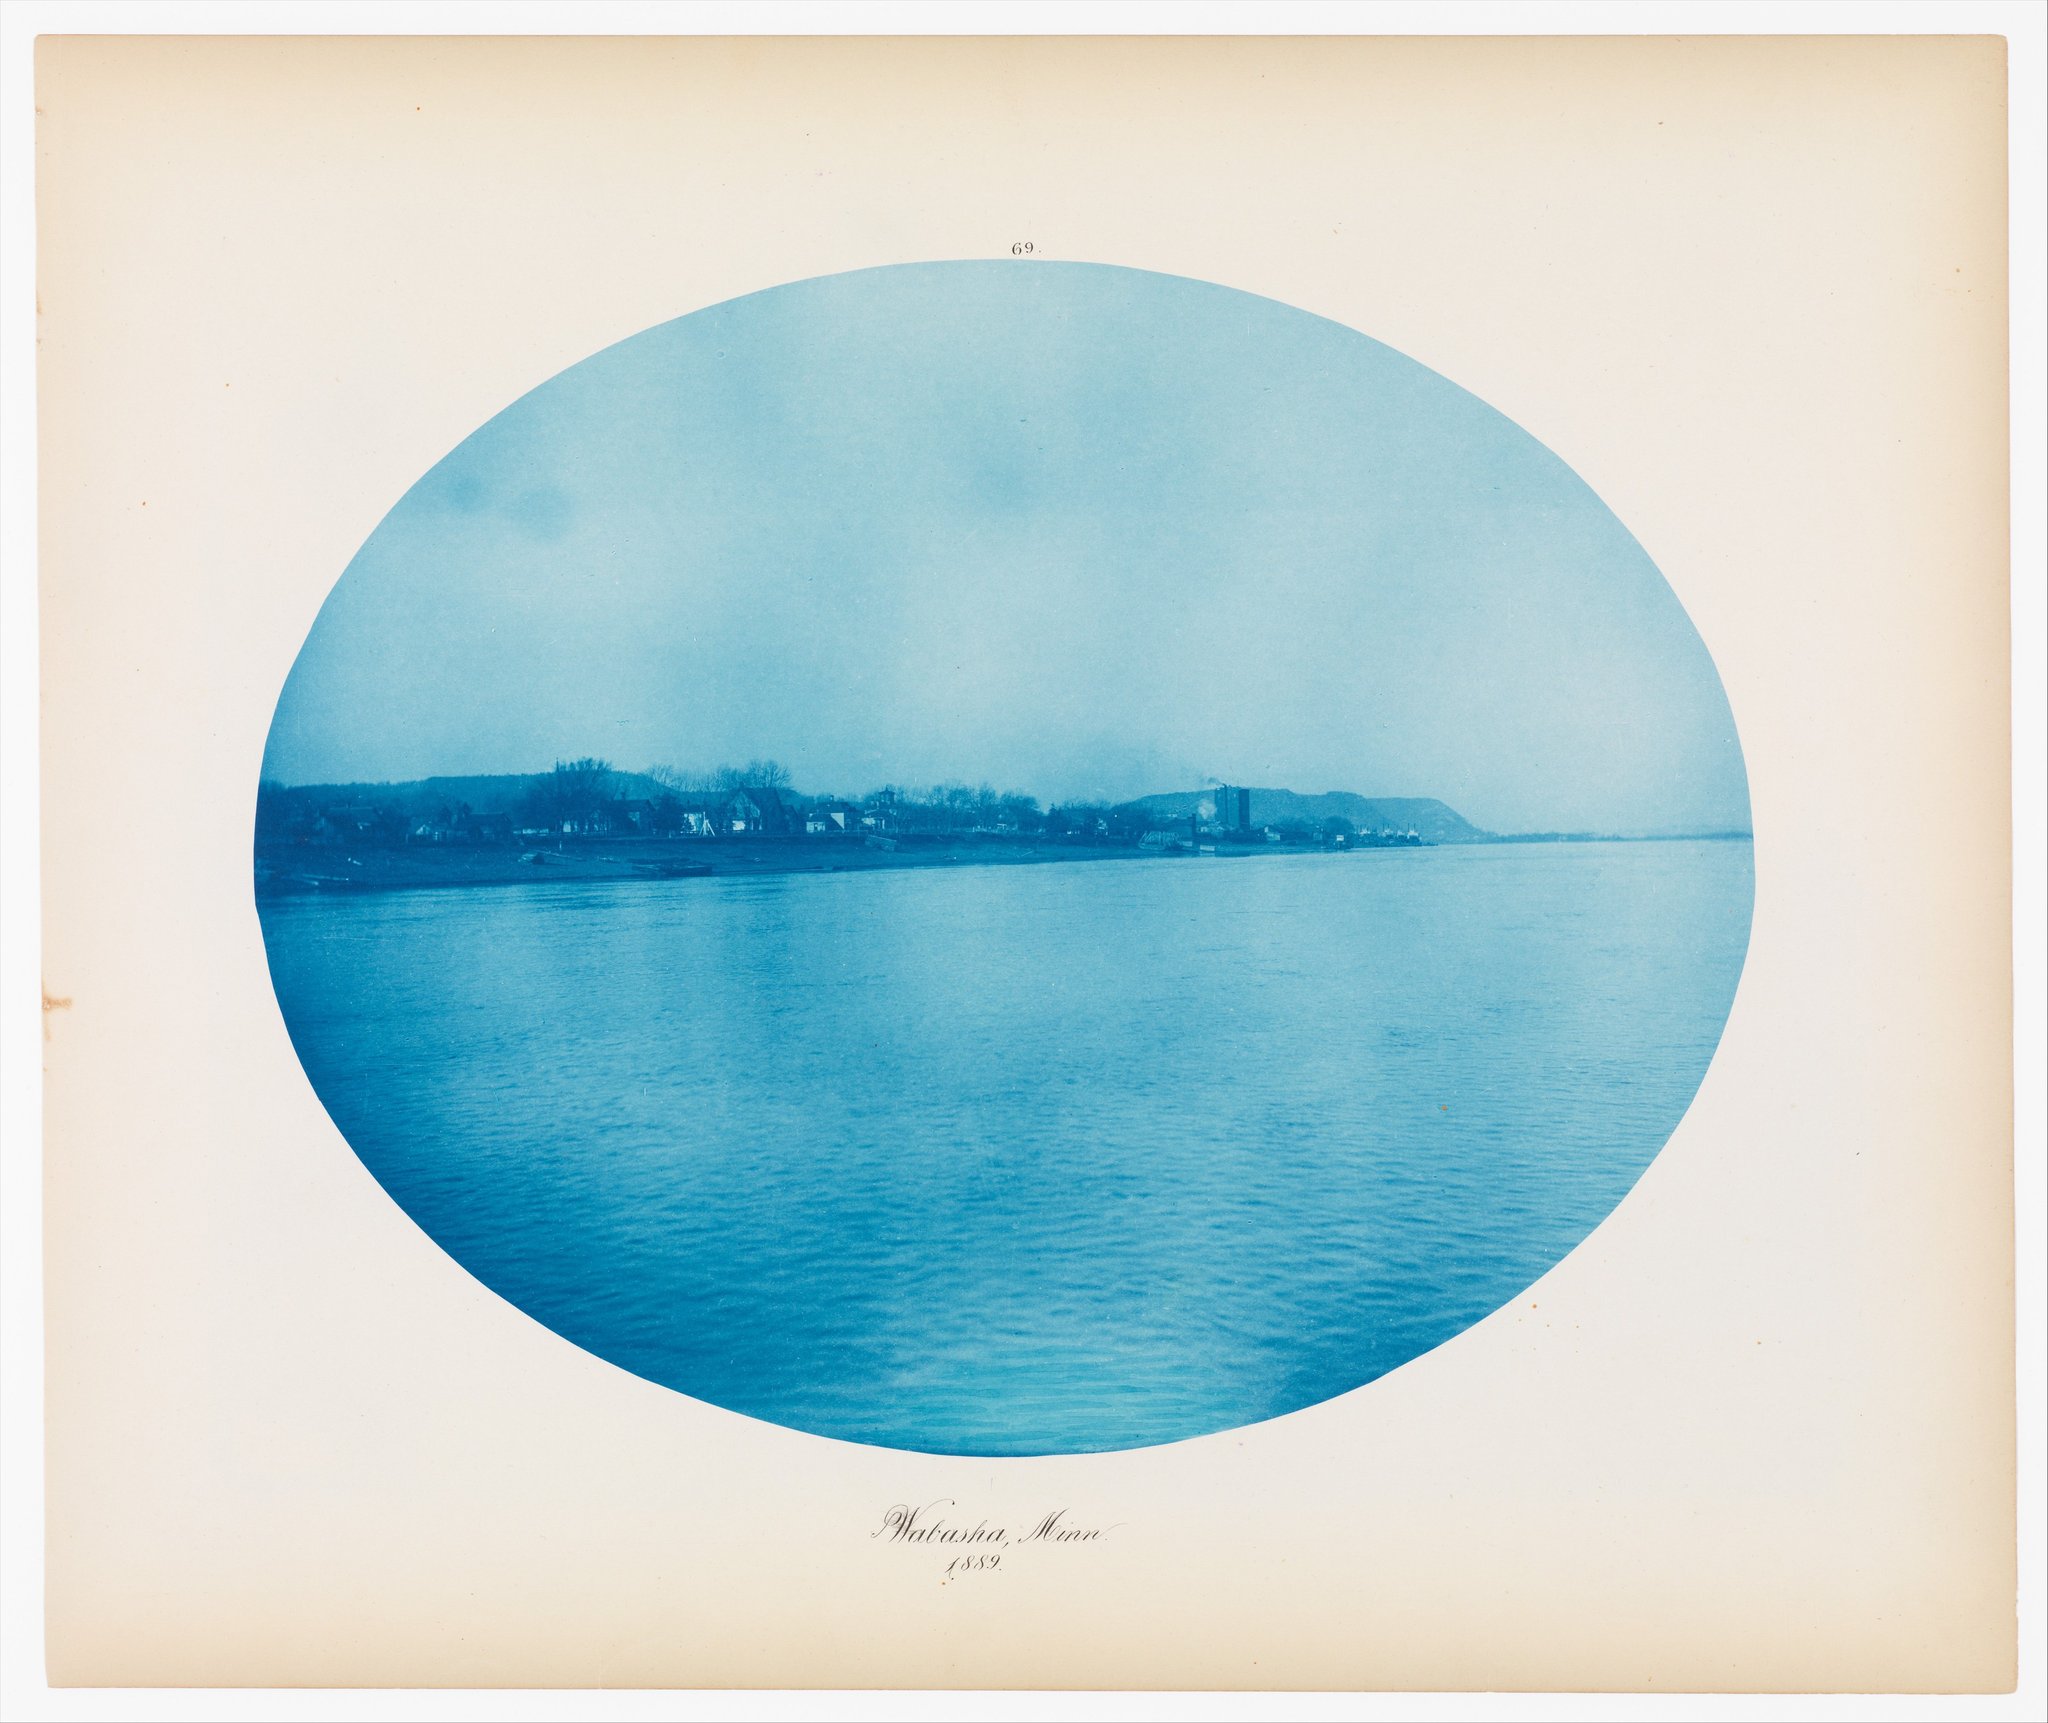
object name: photograph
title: No. 69. Wabasha, Minnesota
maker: henry p. bosse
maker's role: artist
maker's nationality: american, born germany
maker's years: 1844-1893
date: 1889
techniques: cyanotype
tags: landscapes